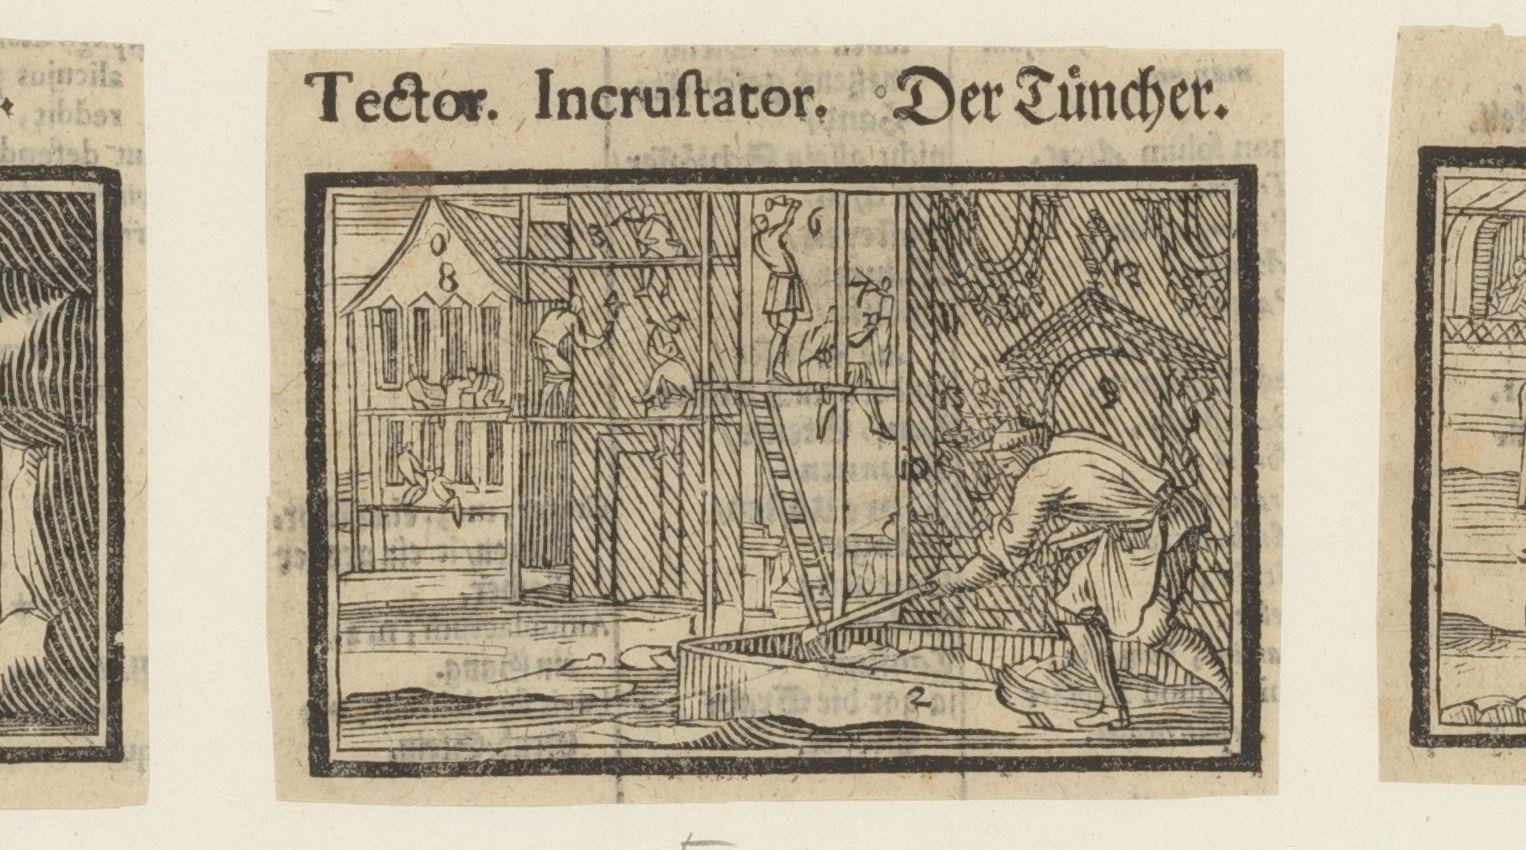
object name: book illustration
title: Tector. Incrustator. Der Luncher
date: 1719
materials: paper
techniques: letterpress printing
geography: nuremberg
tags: handicrafts, craftsman at work, handicrafts ~ clay, sand, chalk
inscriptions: stamp, collector's mark: Lugt 1641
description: Op de voorgrond roert een man in een lage bak met mortel. Op de steigers worden verschillende werkzaamheden verricht, zoals het afbikken van de oude stuclaag en het aanbrengen van een nieuwe. Rechts verschillende decoratieve ornamenten, waaronder een portaal en een vaas. Onderwerpsrubrieken binnen de Atlas Zeden en Gewoonten: Handel, Nijverheid en Verkeer, Beroep en bedrijf, Complete suites.